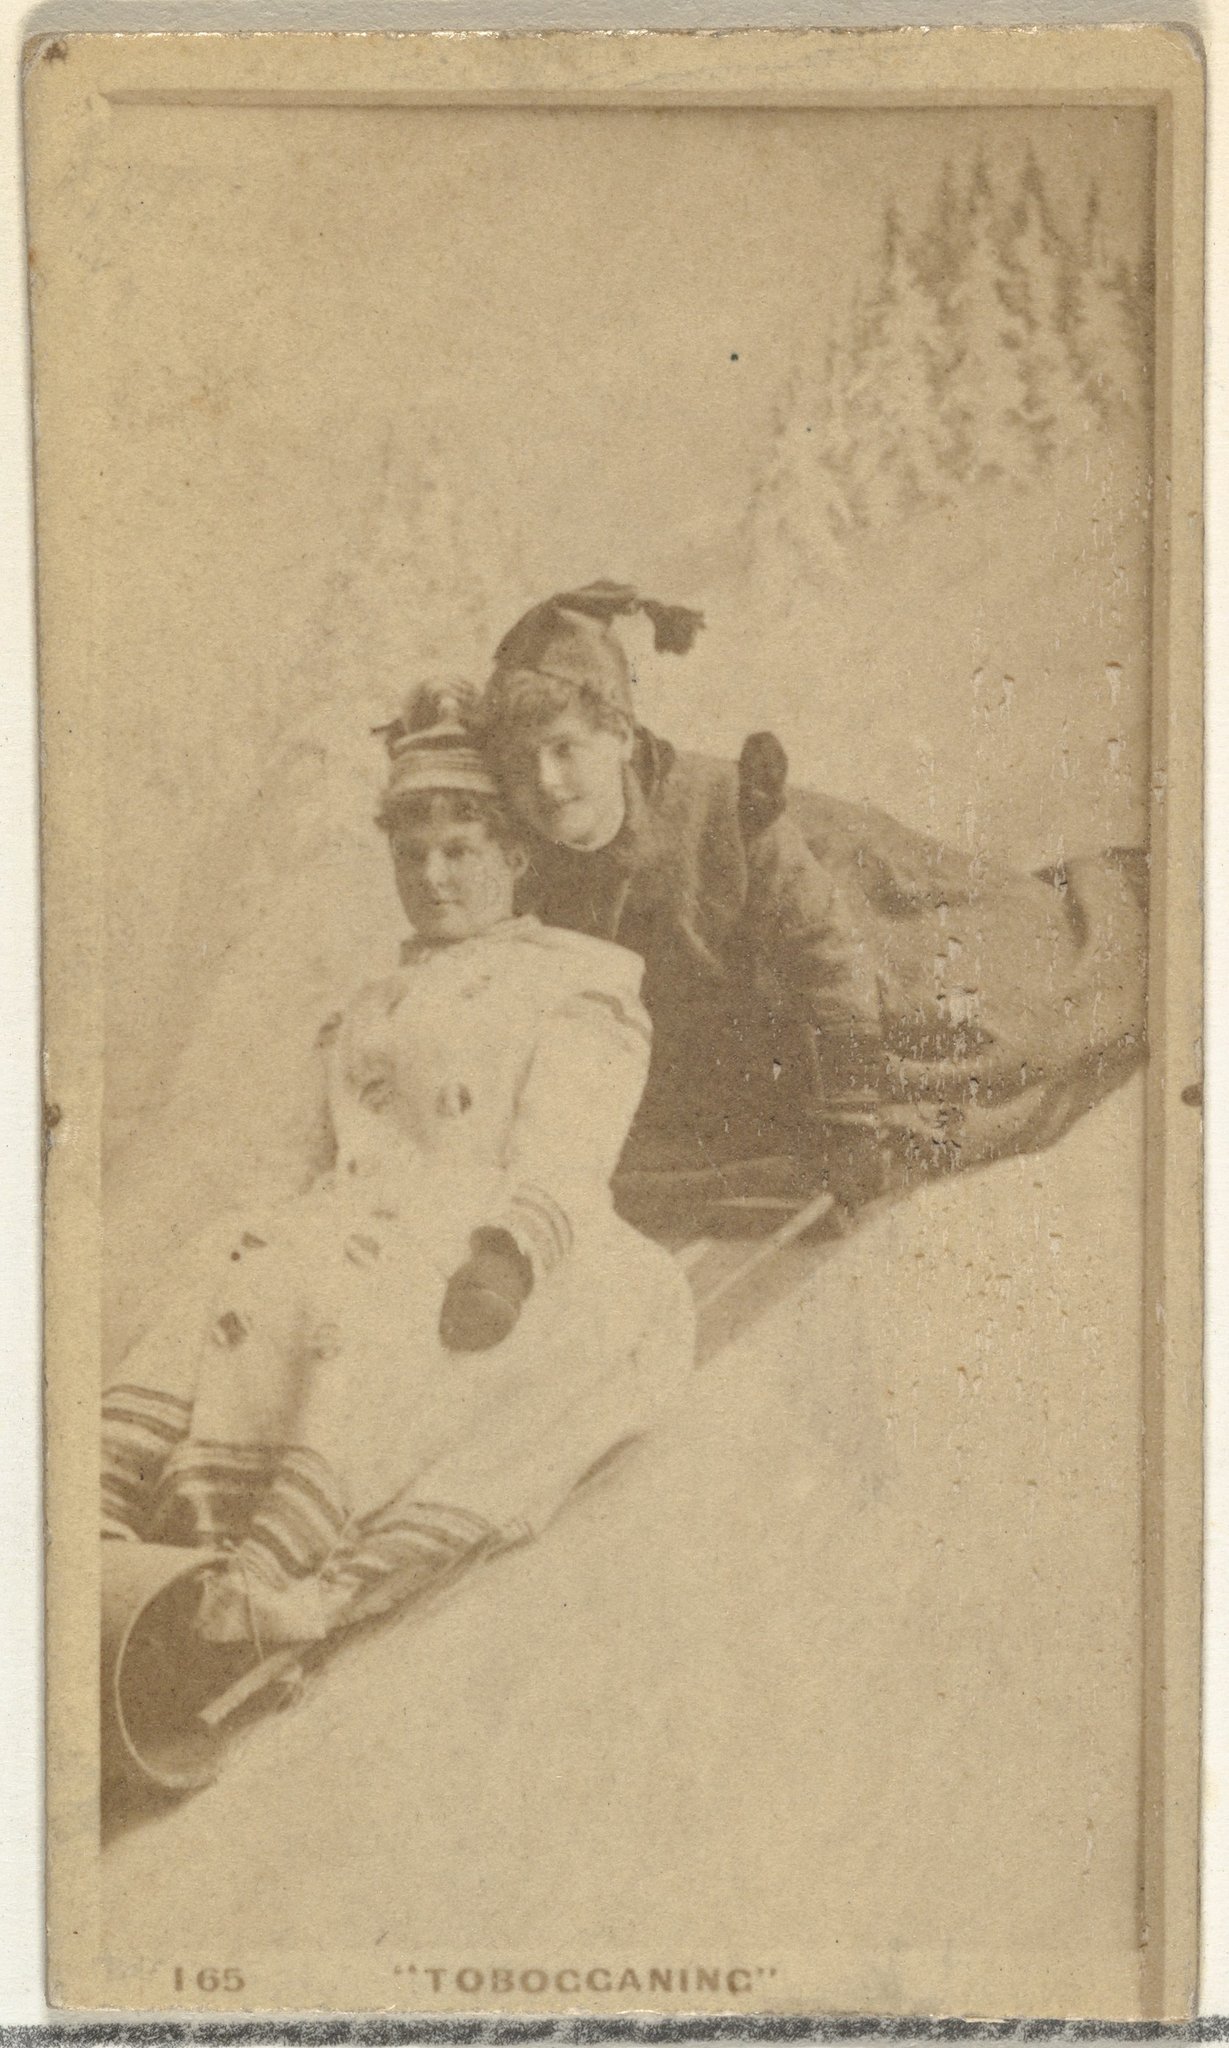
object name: photograph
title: Card Number 165, Tobogganing, from the Actors and Actresses series (N145-7) issued by Duke Sons & Co. to promote Duke Cigarettes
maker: w. duke, sons & co.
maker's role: publisher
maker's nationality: american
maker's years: 1870-1920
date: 1880-1889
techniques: albumen silver print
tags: portraits,women,actresses,sleighs